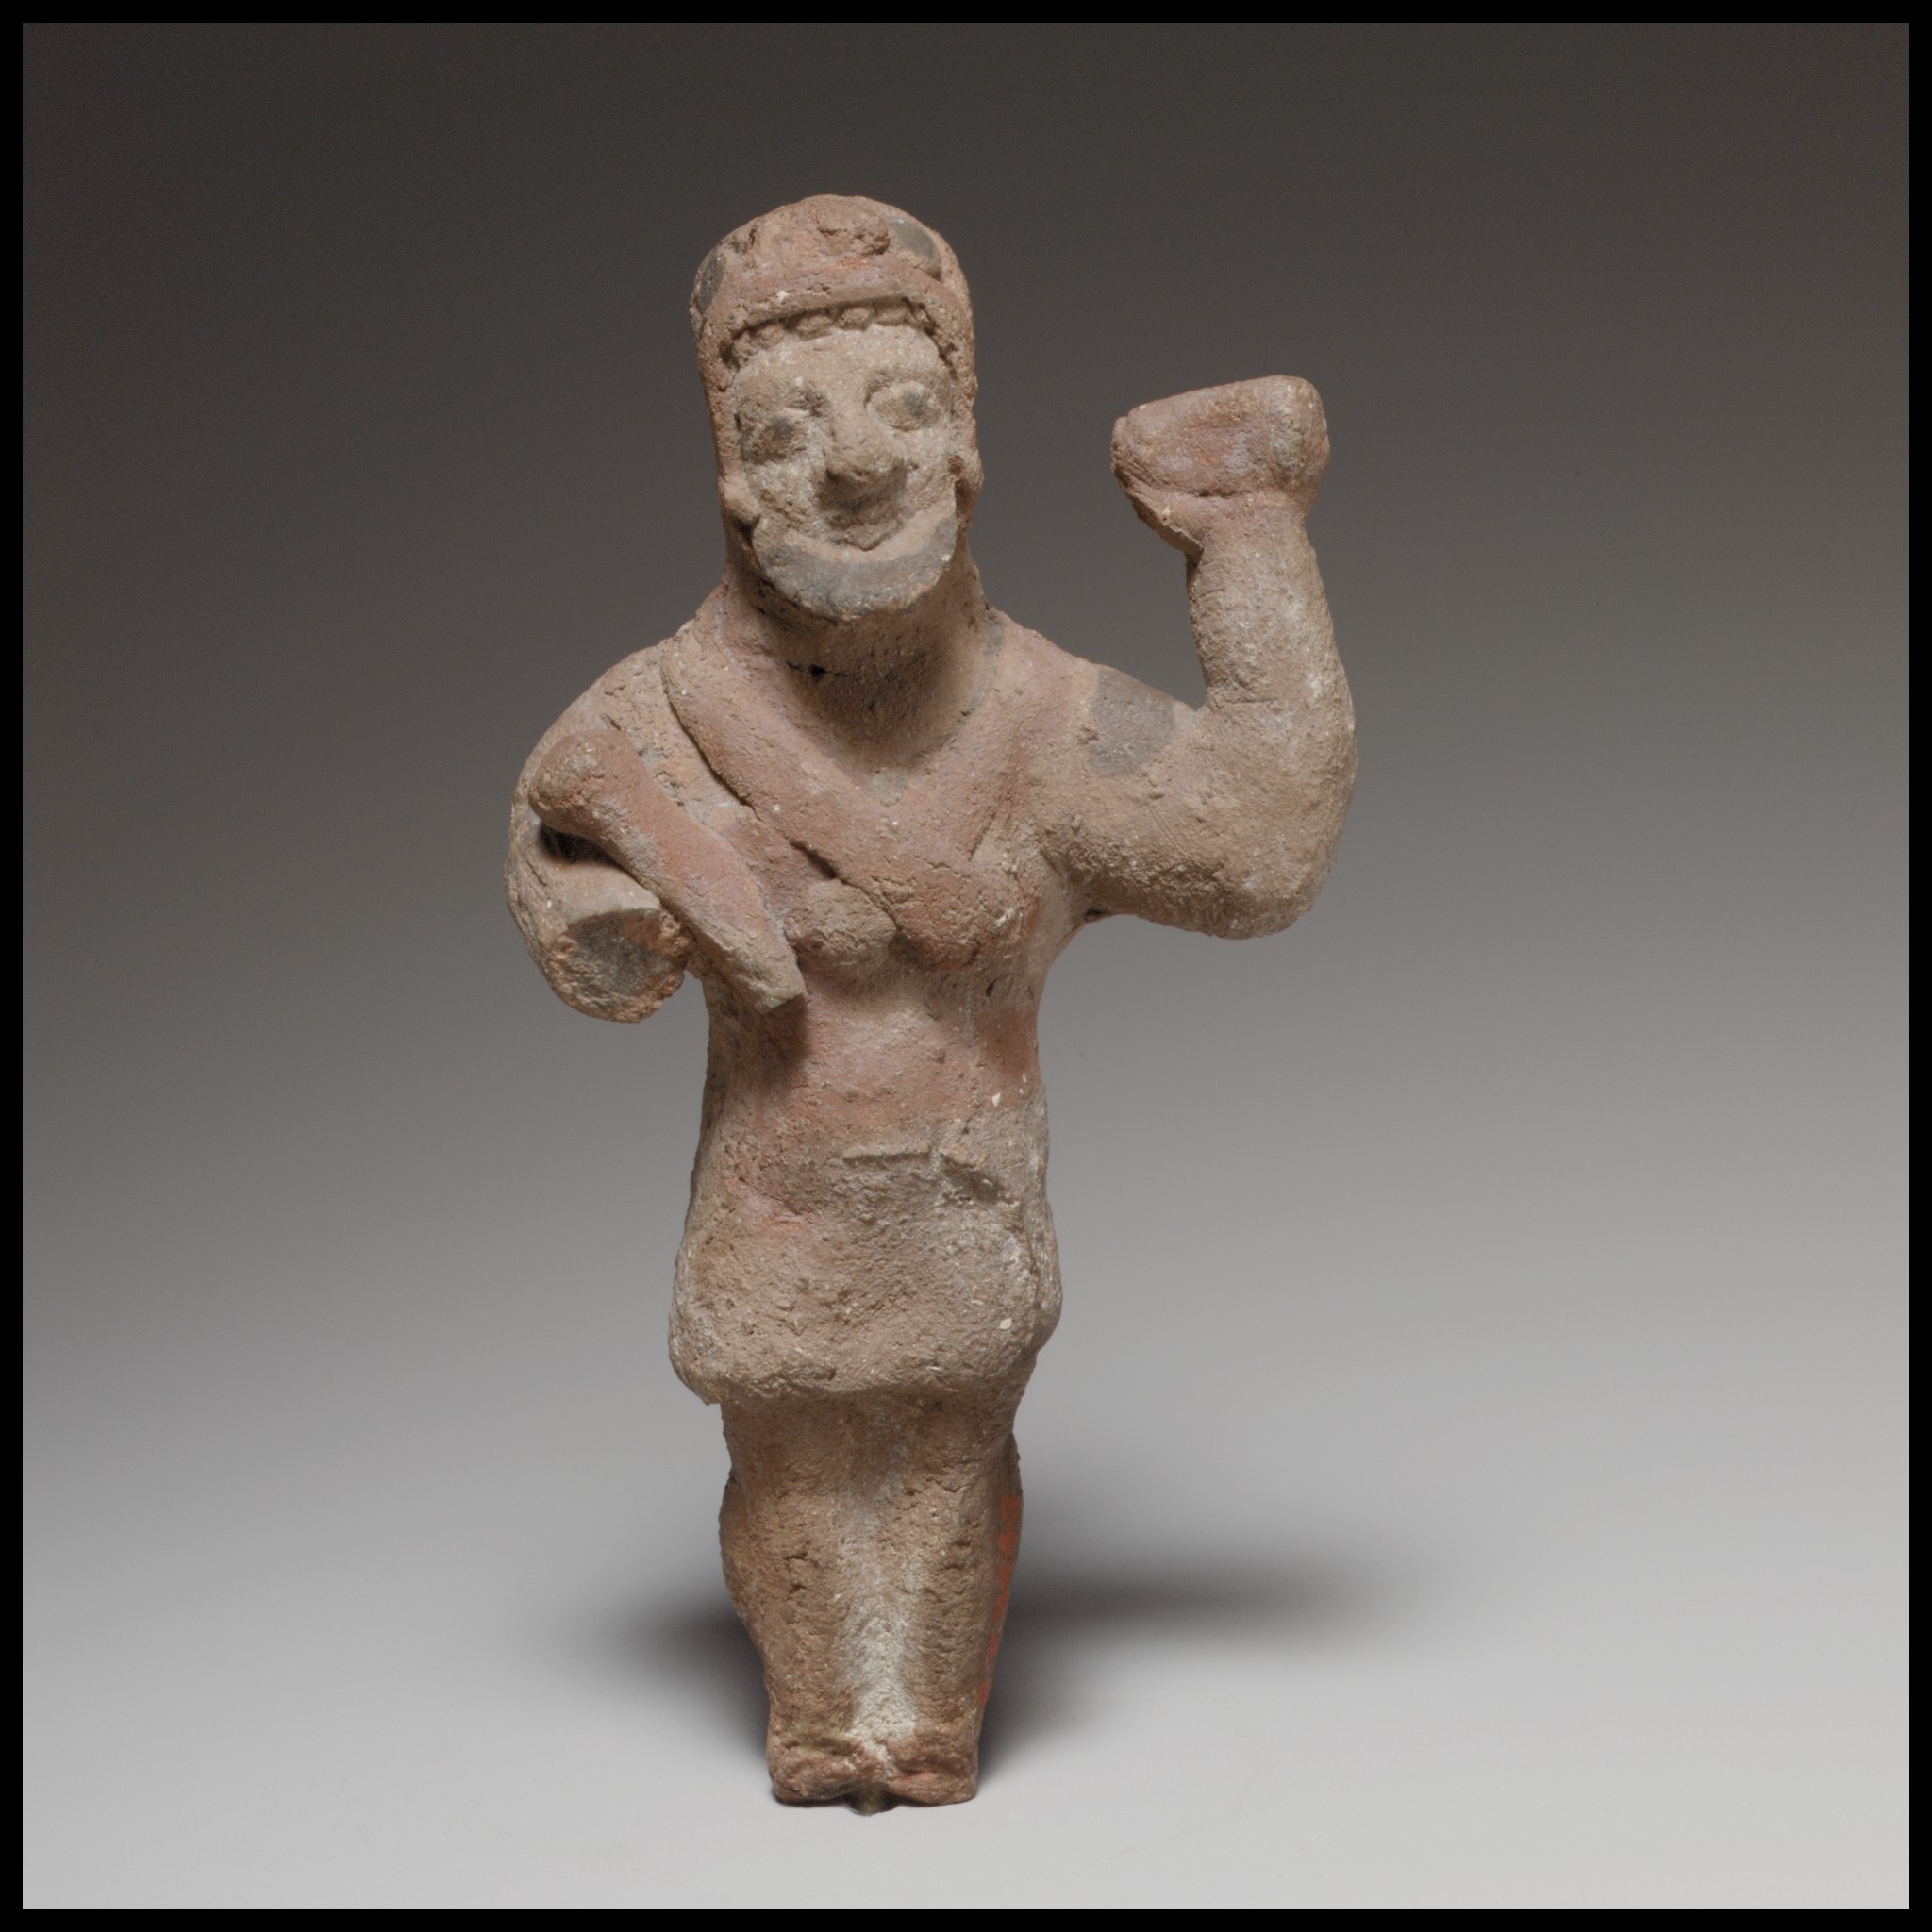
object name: statuette of herakles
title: Standing Herakles (?)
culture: cypriot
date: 600-480 BCE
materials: terracotta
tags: herakles